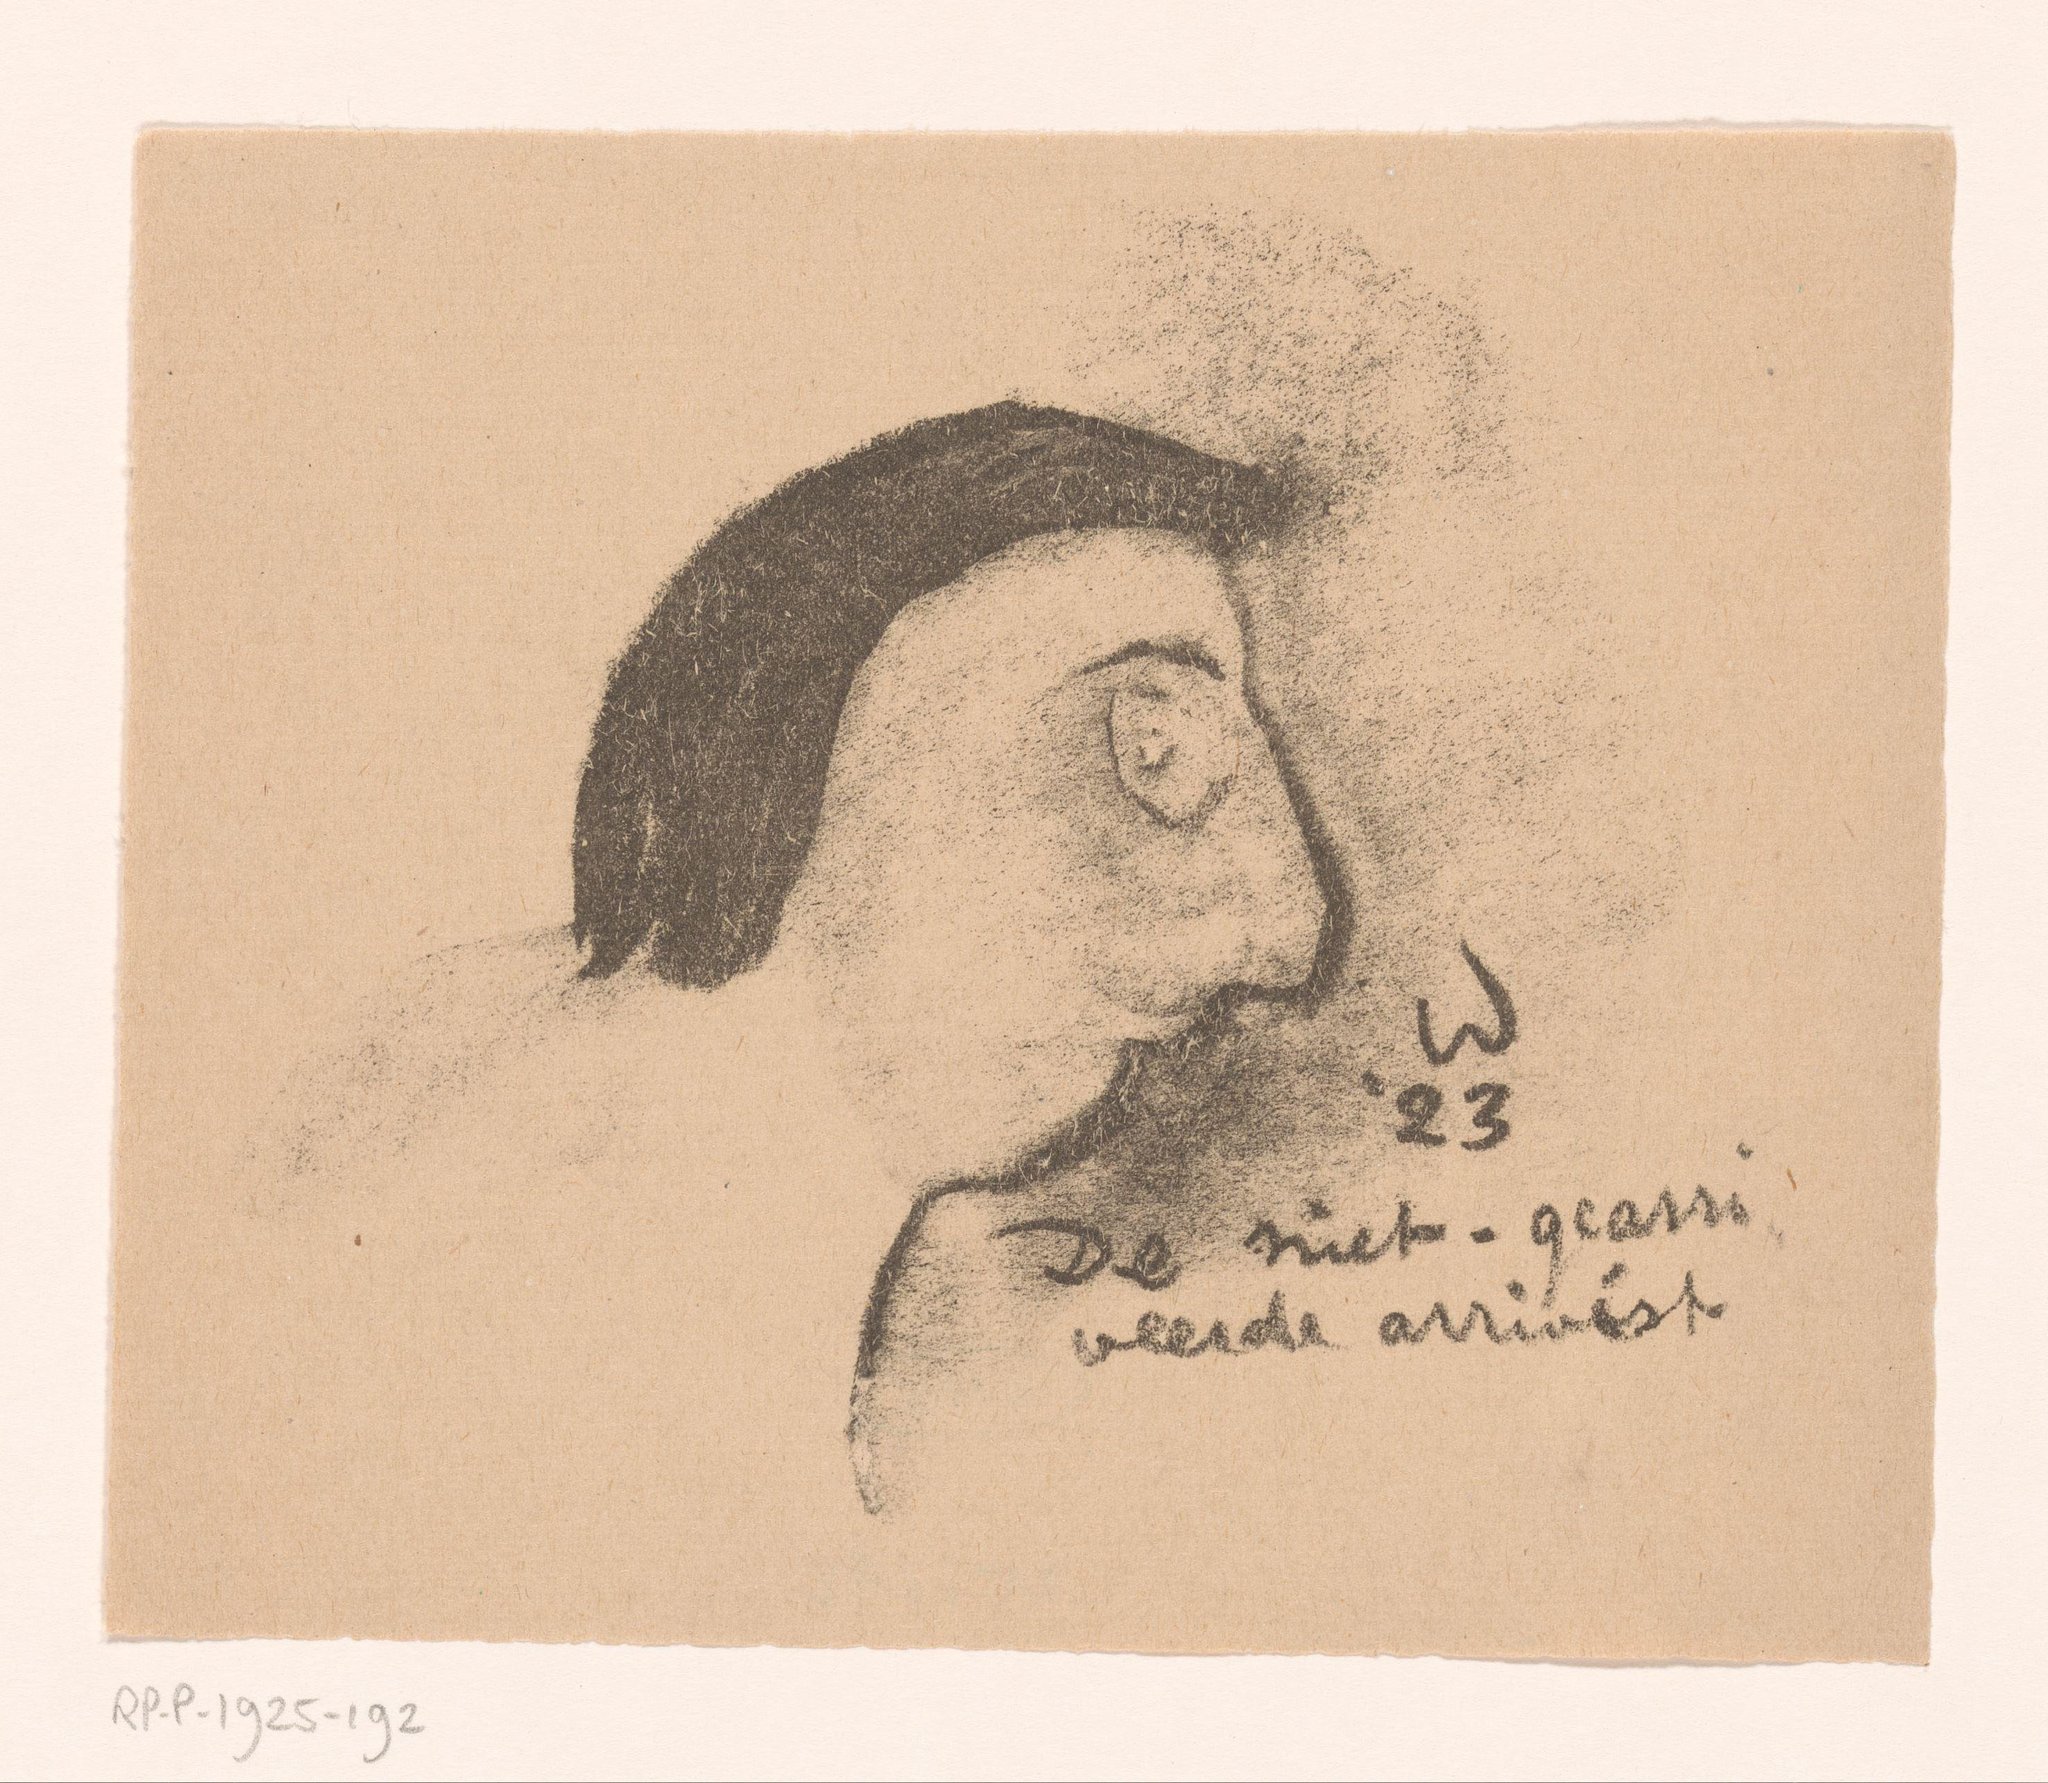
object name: print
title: Idealisten II en verdere Kanttekeningen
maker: erich wichmann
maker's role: print maker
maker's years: 1890-1929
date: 1923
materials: paper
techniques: lithograph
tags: caricatures (human types)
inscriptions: collector's mark: Lugt 2228